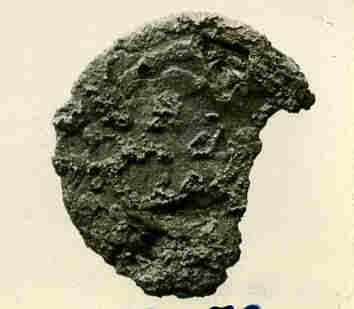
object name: coin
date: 734-766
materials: copper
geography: iran